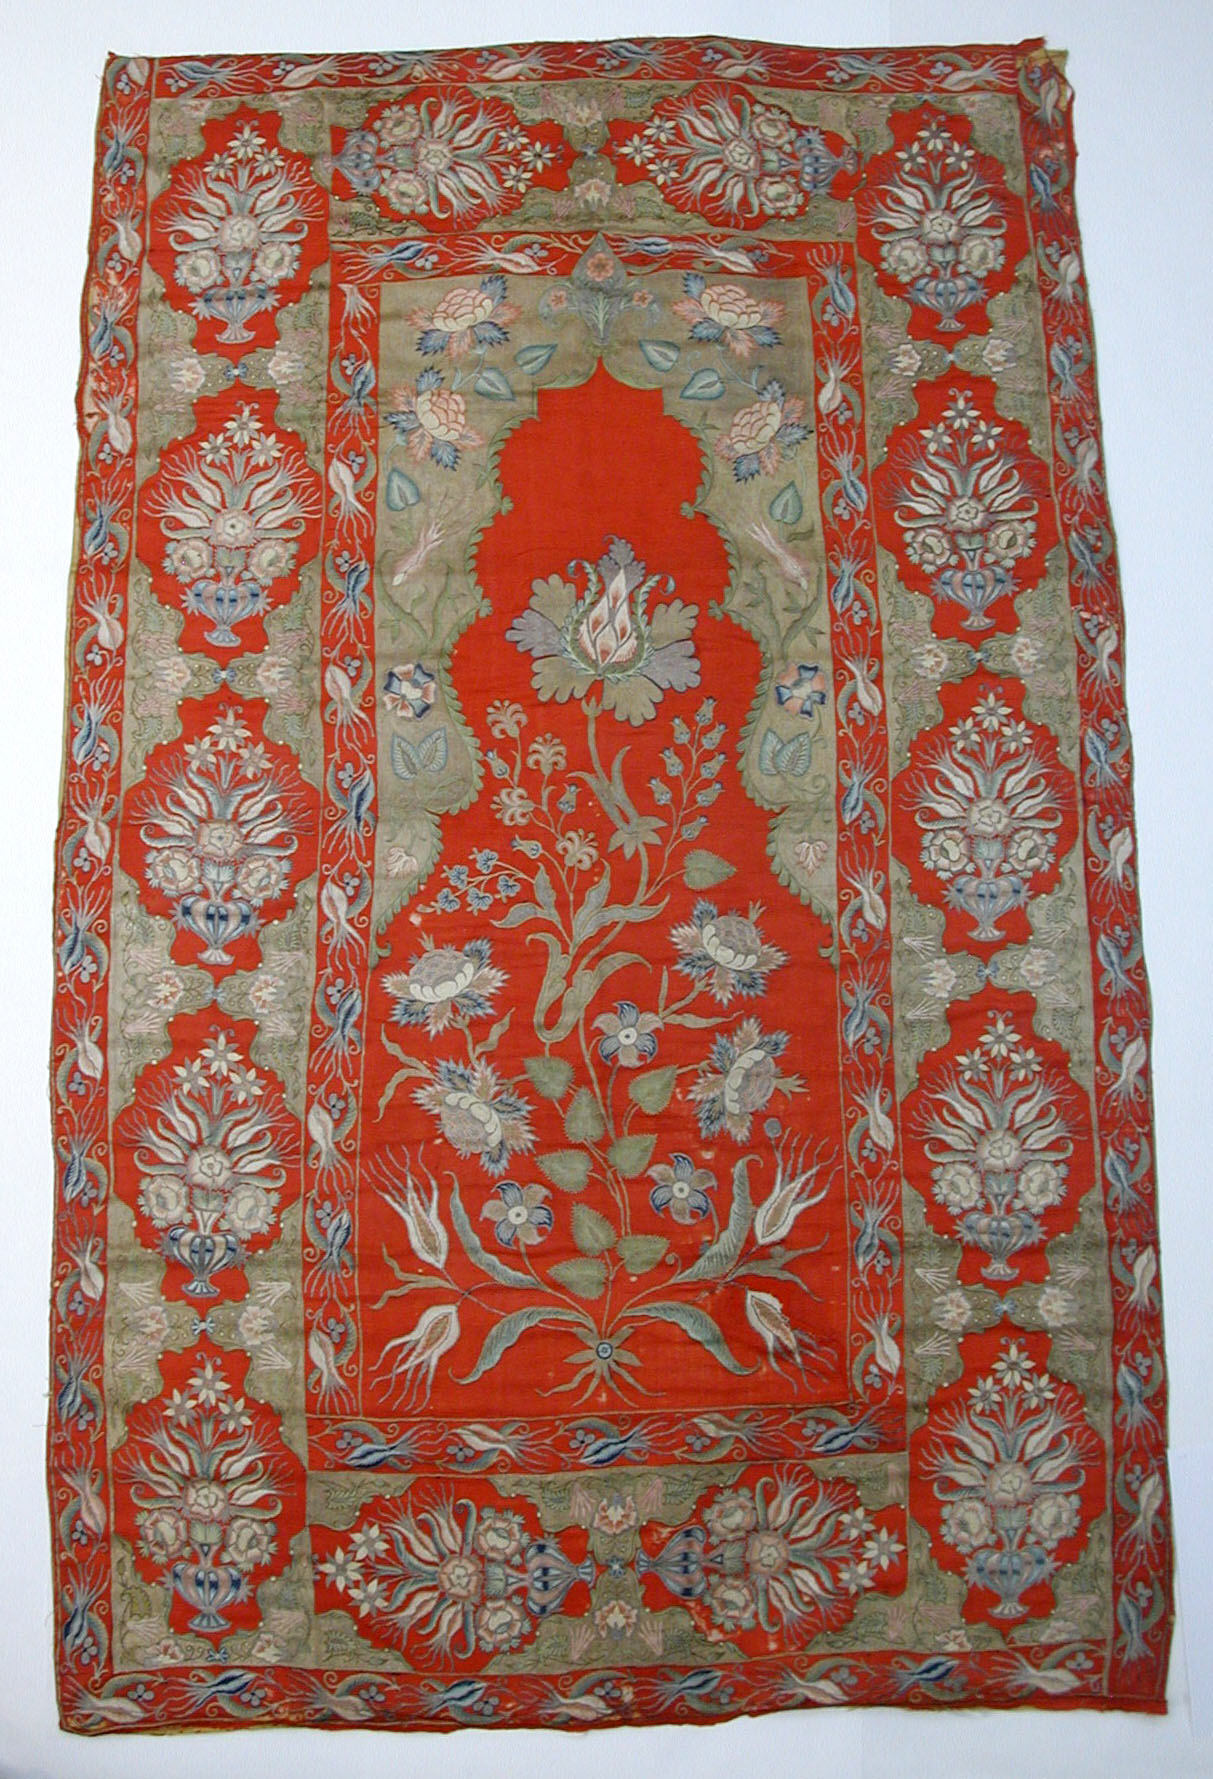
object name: cover or hanging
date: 1801-1833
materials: metal thread, silk, wool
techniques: embroidery, weave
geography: turkey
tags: flowers